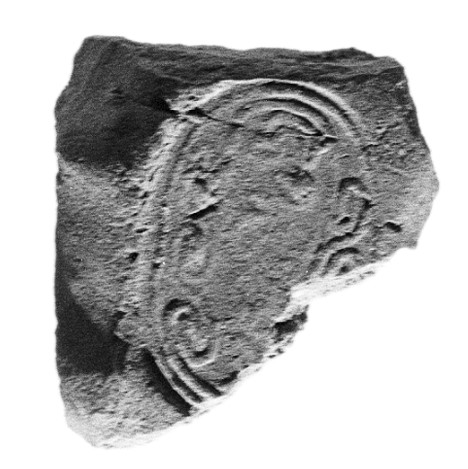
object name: sealing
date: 1981-1640 BCE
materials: mud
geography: egypt